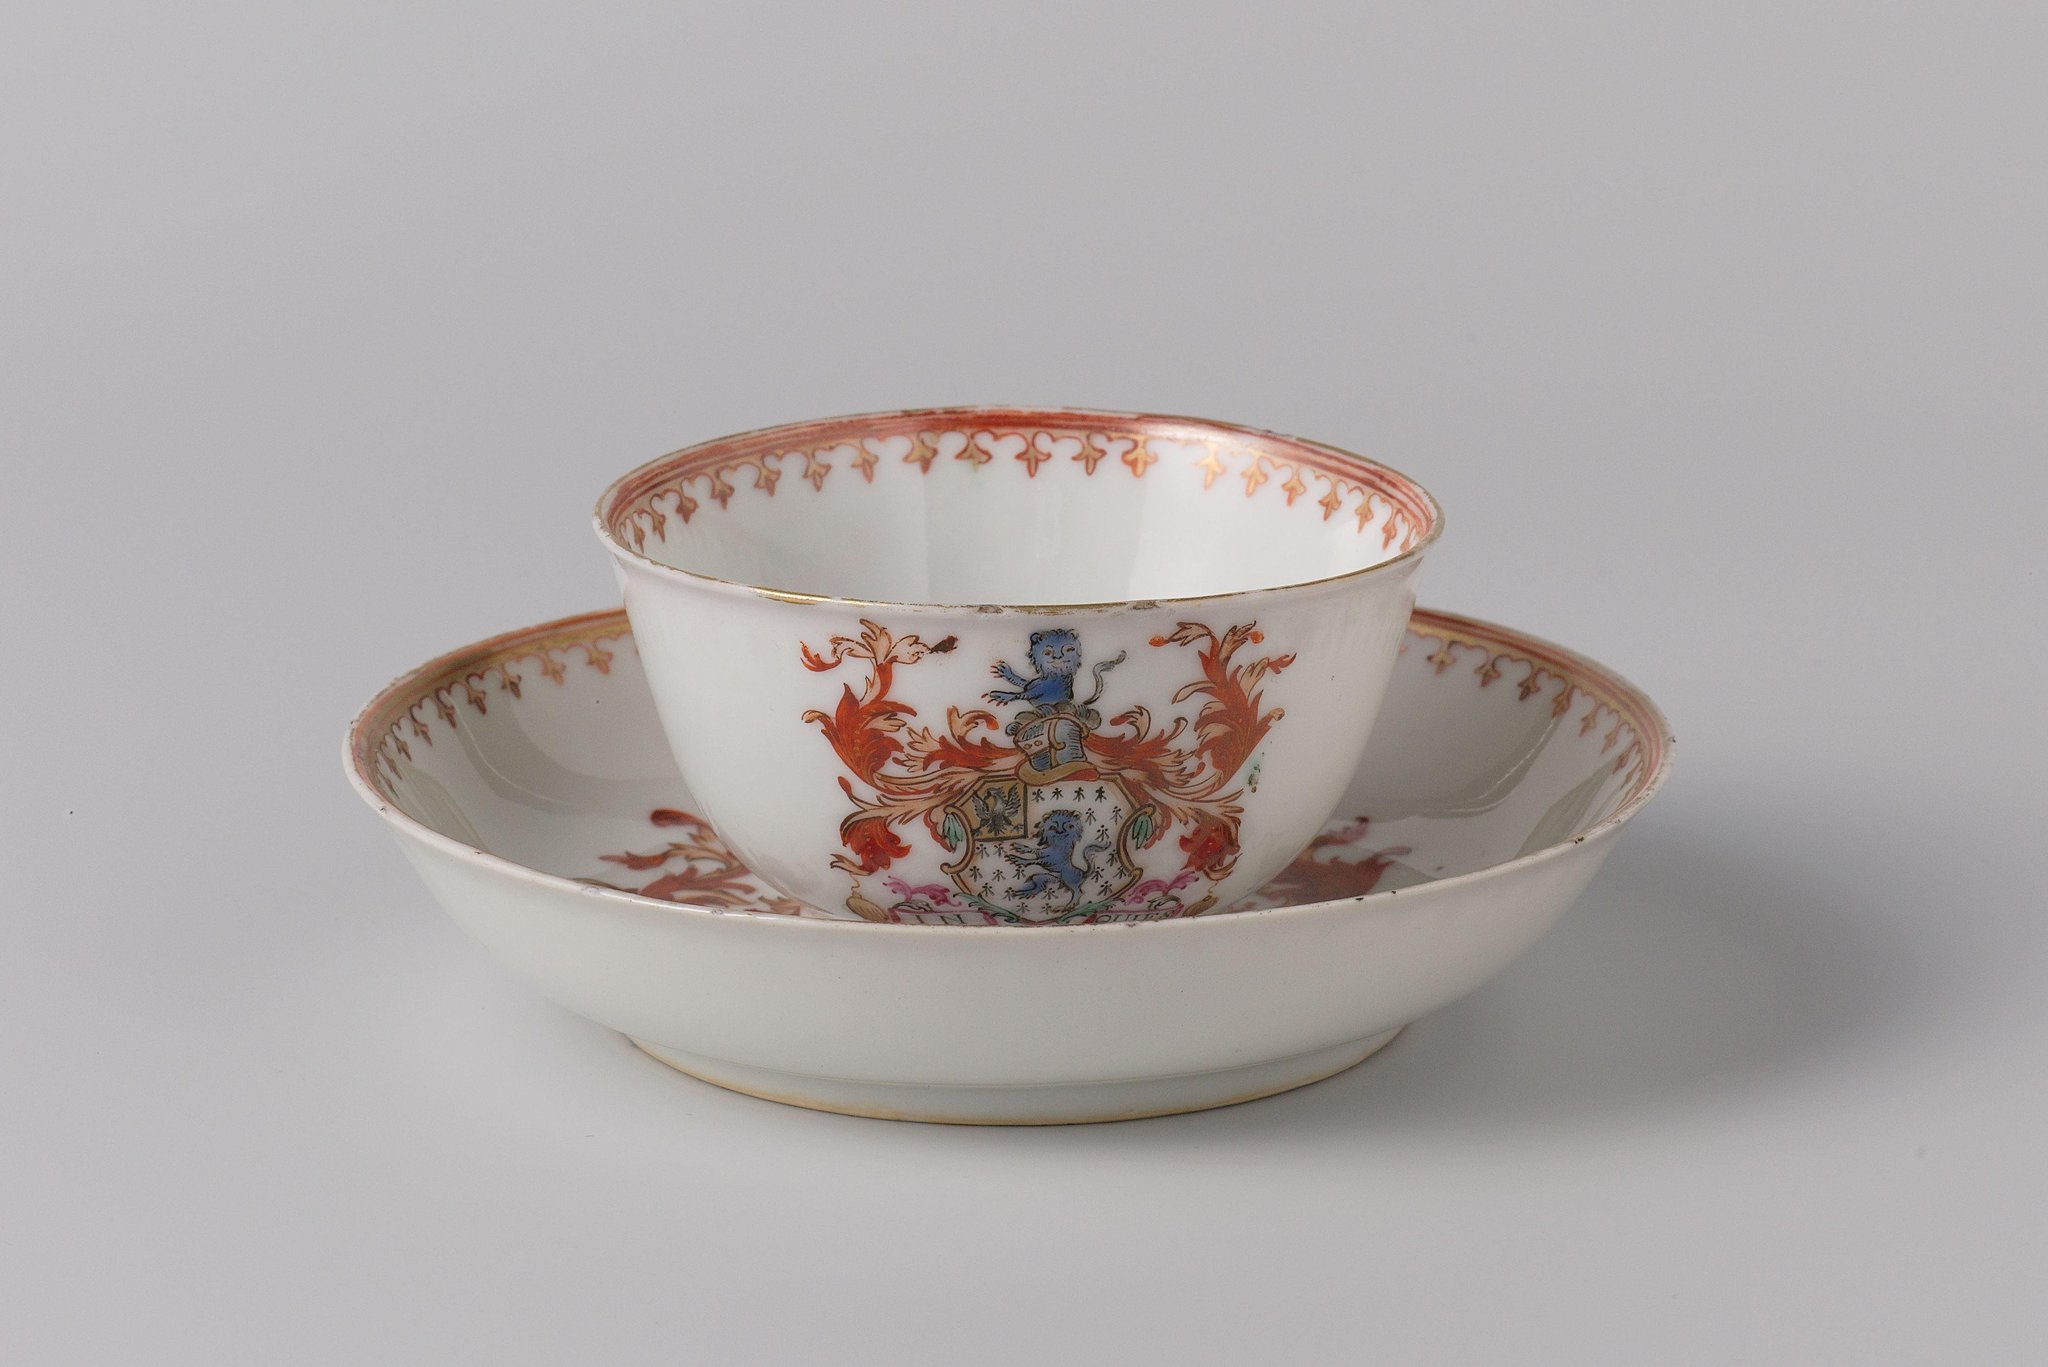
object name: kop en schotel, kop en schotel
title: Bell-shaped cup with the arms of the Edwards family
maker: Anonymous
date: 1740-1760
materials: glaze, gold, paint, porcelain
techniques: firing, gilding, turning, vitrification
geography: china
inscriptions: label: ‘Edwards of Iyrington, Norfolk’, inscription: ‘IN CAELO QUIES’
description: Klokvormige kop van porselein, beschilderd op het glazuur in blauw, rood, roze, groen, zwart en goud. Op de wand het wapen van de familie Edwards met een blauwe leeuw op een witte achtergrond met zwarte tekens; in de linker hoek een vak met een adelaar. Het helmteken is ook een blauwe leeuw, omgeven door acanthusbladeren. Onder het wapen een banderol met het opschrift 'IN CAELO QUIES', 'de rust komt in de hemel'. Op de binnenrand een spearhead-border. Oud label op de onderzijde met 'Edwards of Iyrington, Norfolk'. Wapenporselein met emailkleuren.